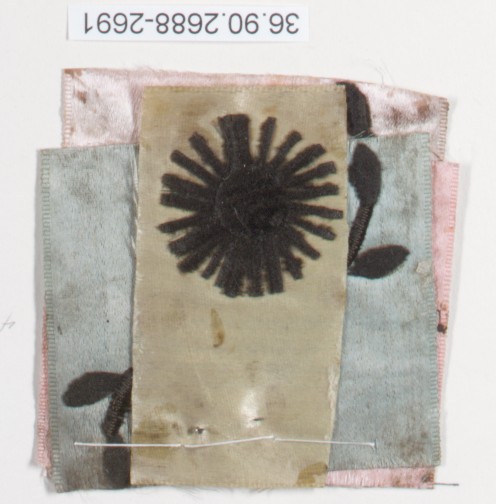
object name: ribbon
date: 1801-1900